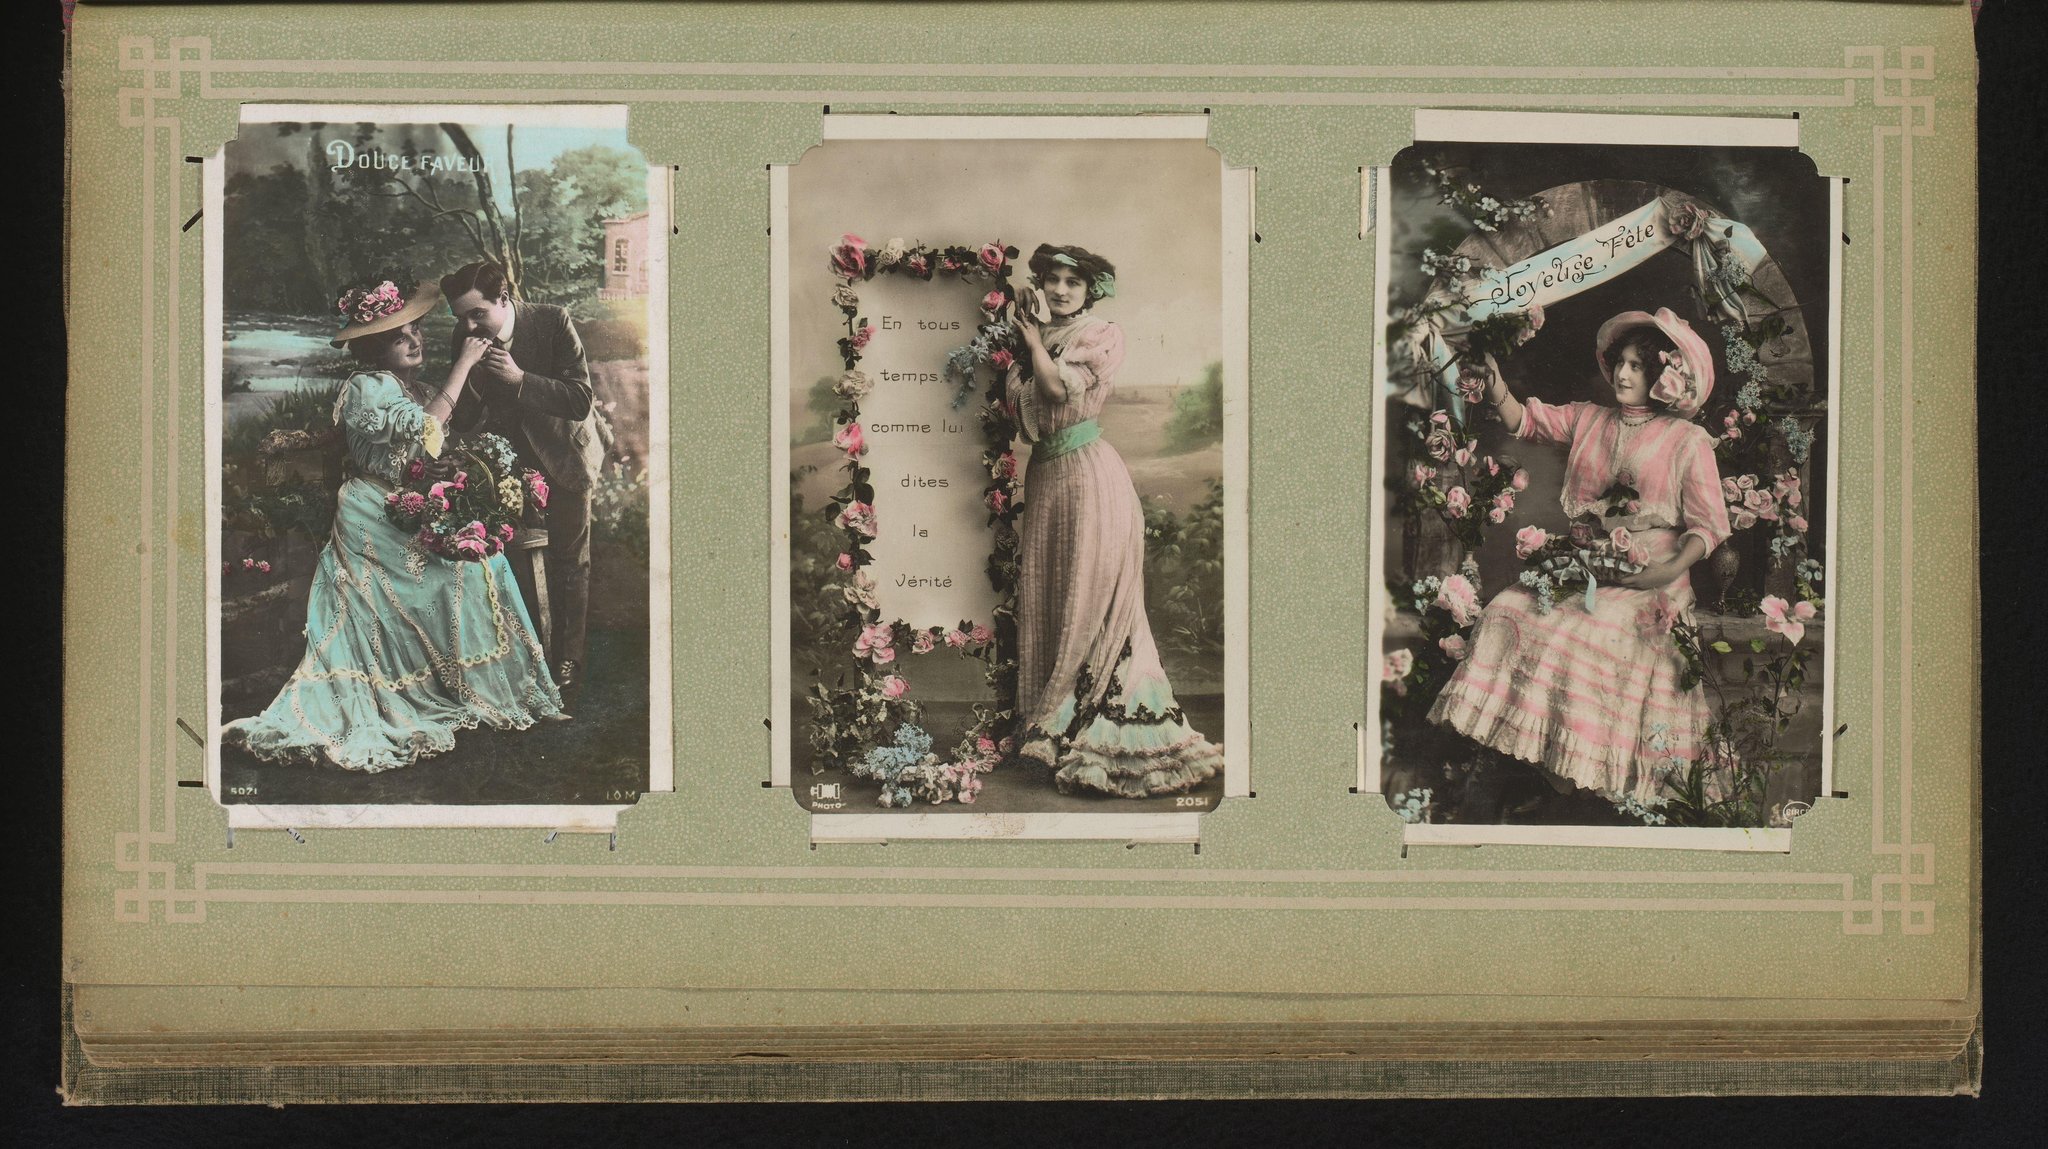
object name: photograph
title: Portret van een paar geliefden en twee portretten van vrouwen met bloemen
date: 1900-1930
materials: cardboard, photographic support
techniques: gelatin silver print, hand coloring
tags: flowers, historical persons - bb - woman, couple of lovers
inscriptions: monogram: ‘LO M’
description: Deze foto's maken deel uit van een album.